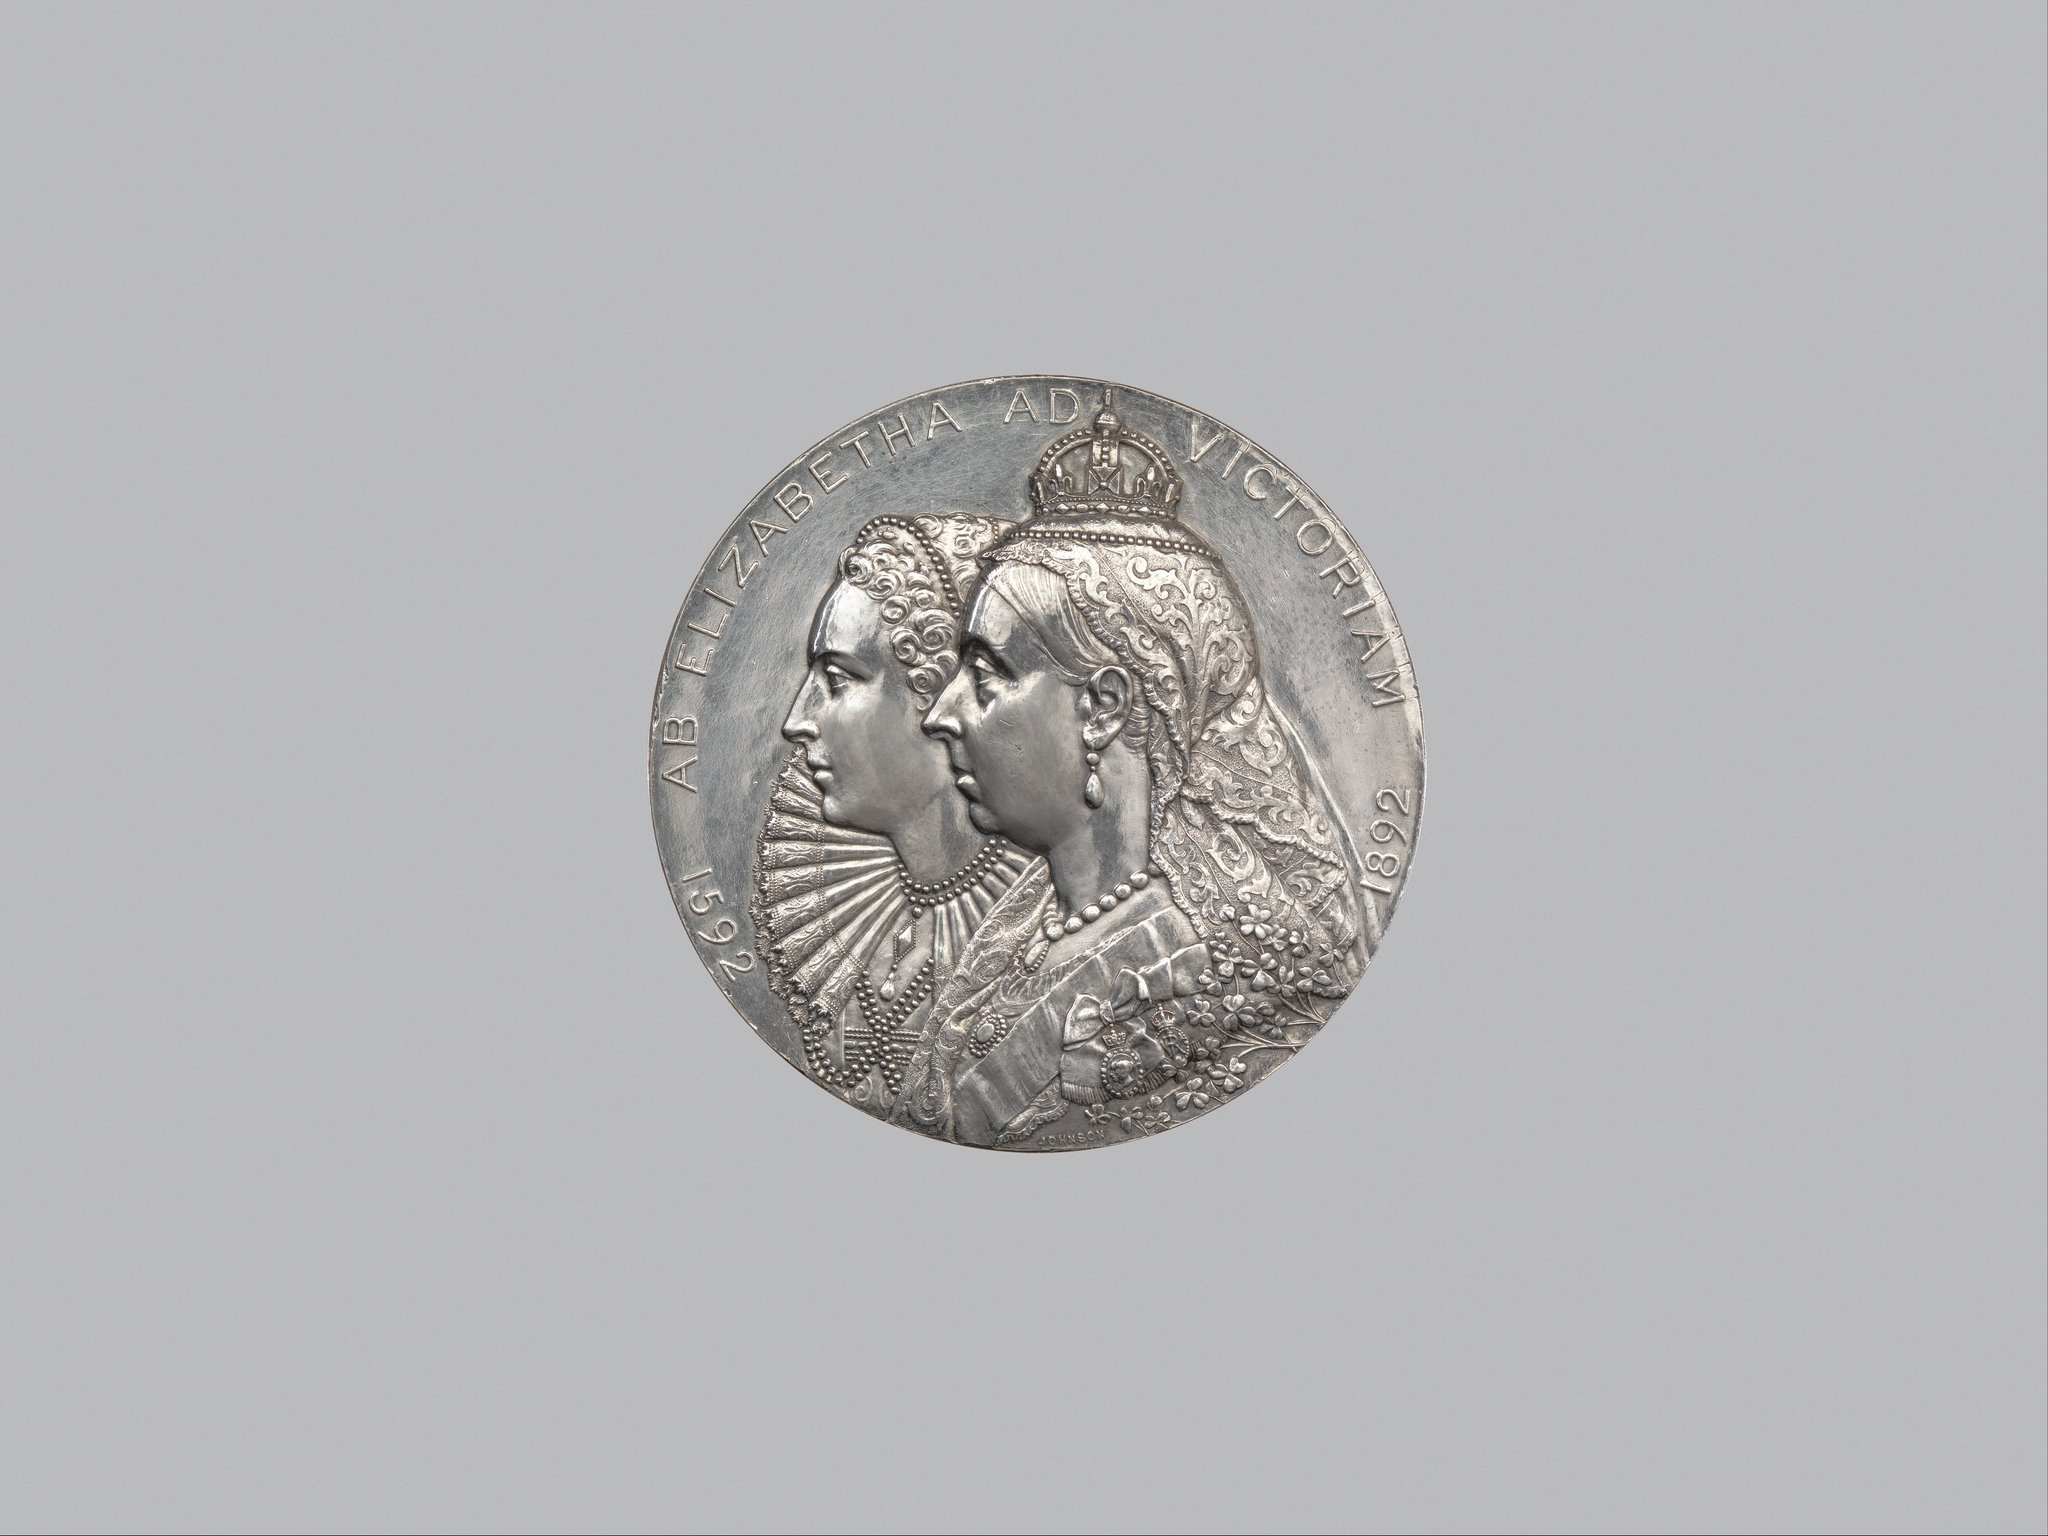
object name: medal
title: Commemorating the Tercentenary of Trinity College, Dublin. 1892.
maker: edmond johnson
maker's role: artist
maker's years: 1850-1950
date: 1892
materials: silver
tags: profiles,women,coat of arms